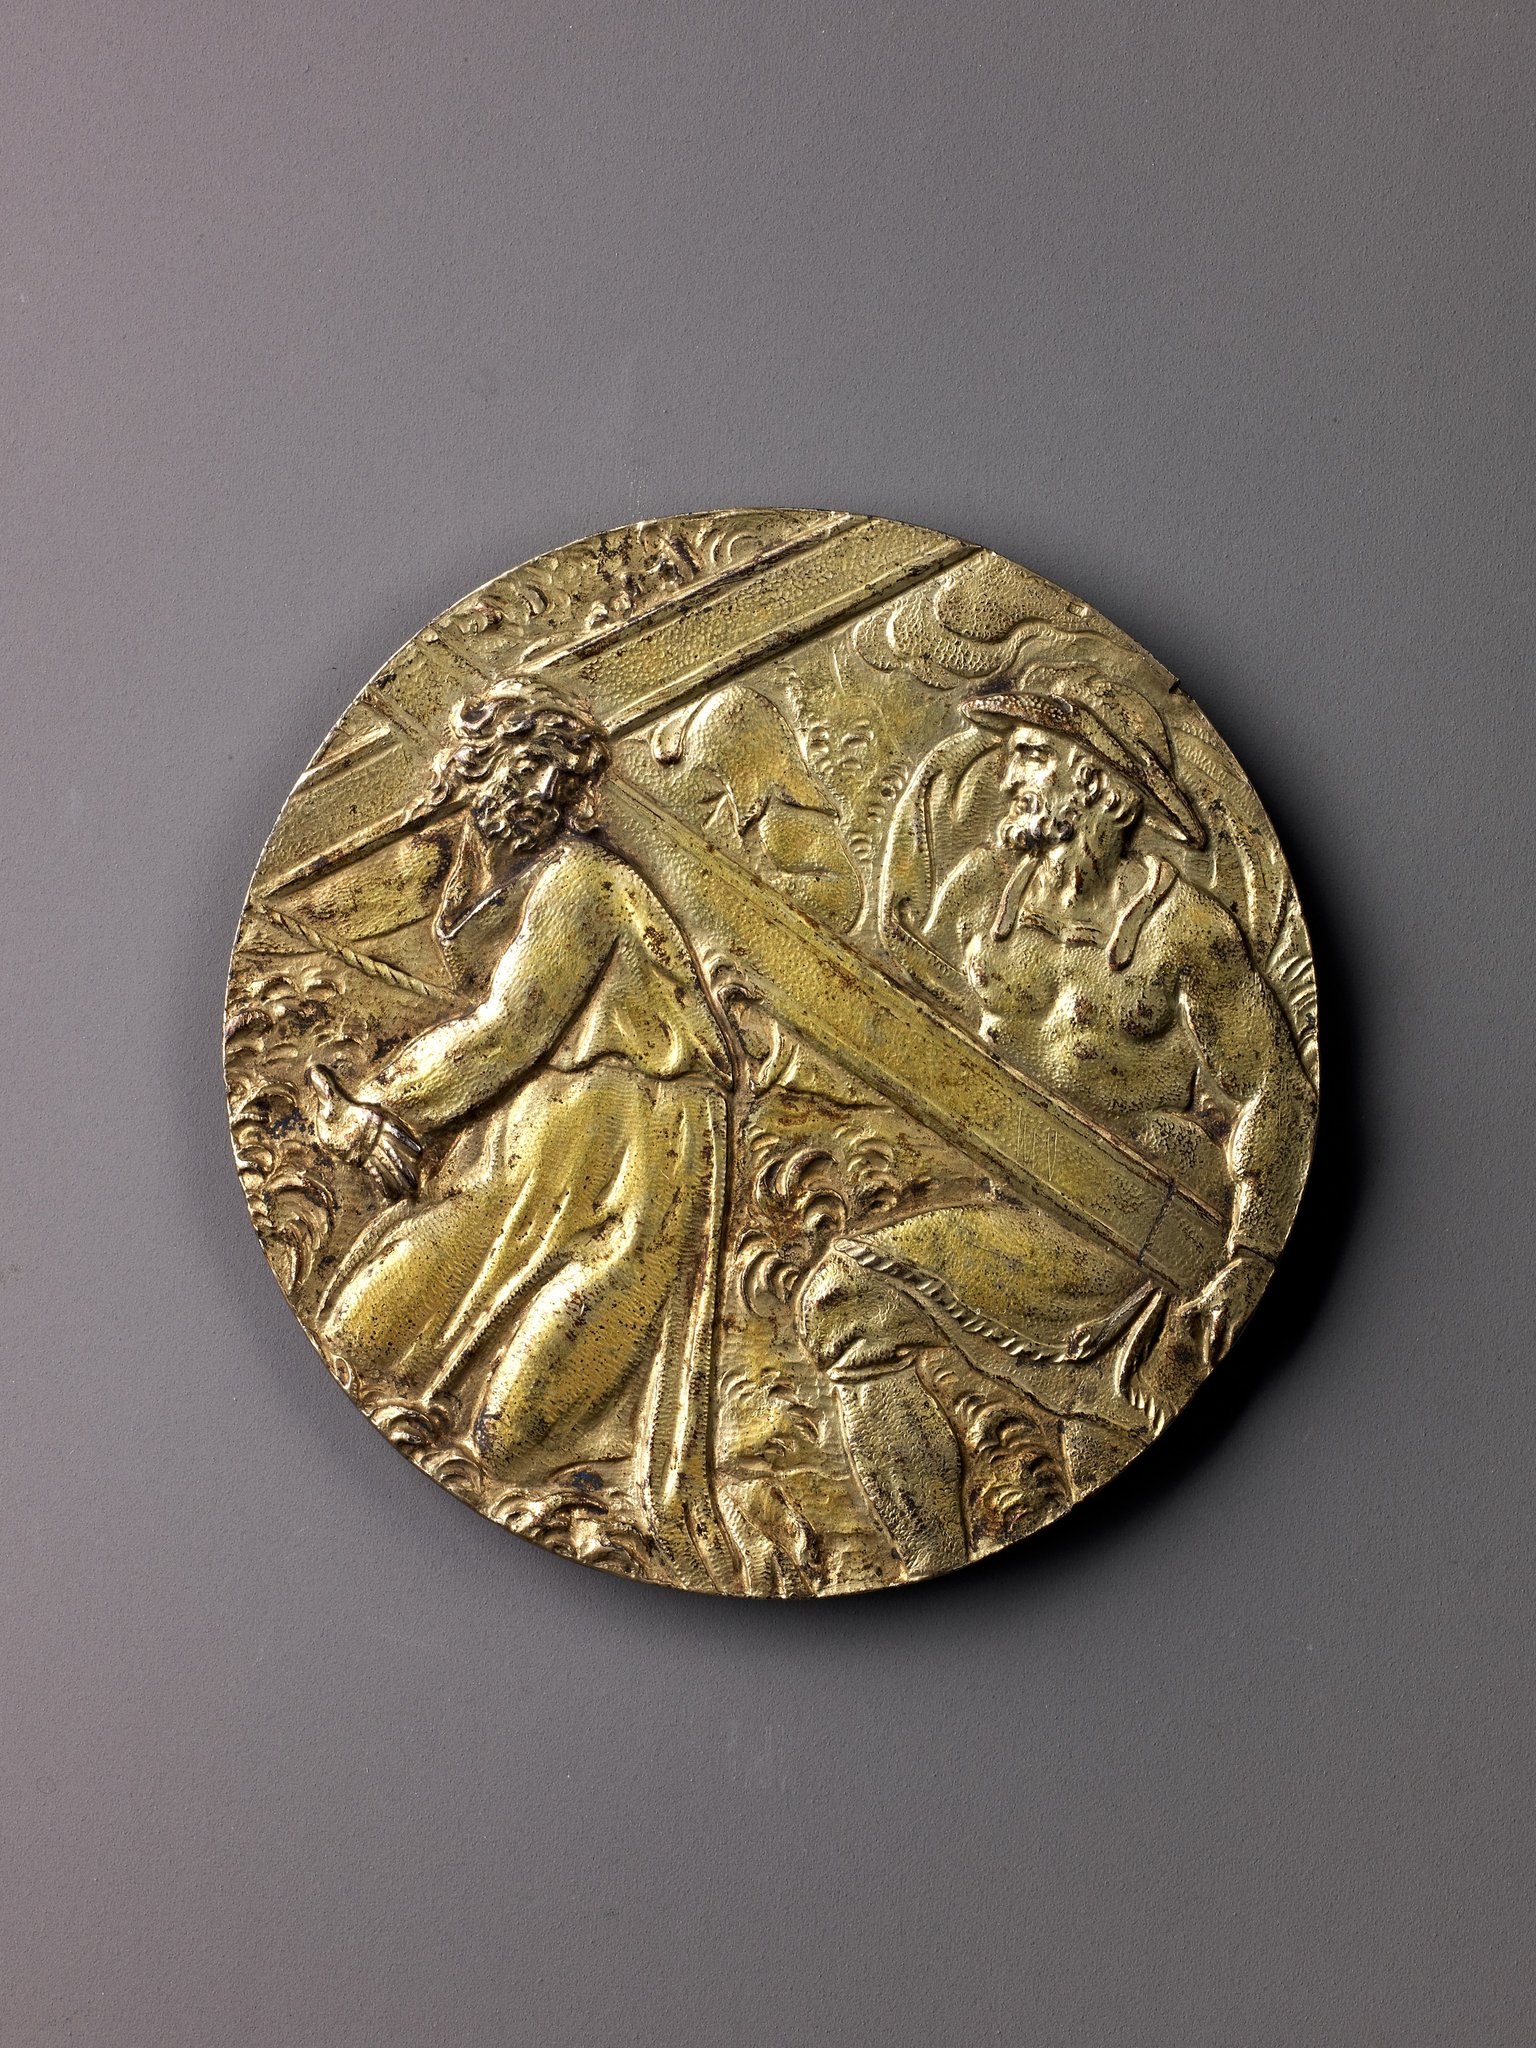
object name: plaquette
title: Christ Carrying the Cross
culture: german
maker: hans andreas anthoni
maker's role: artist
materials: silver gilt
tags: christ,bearing the cross